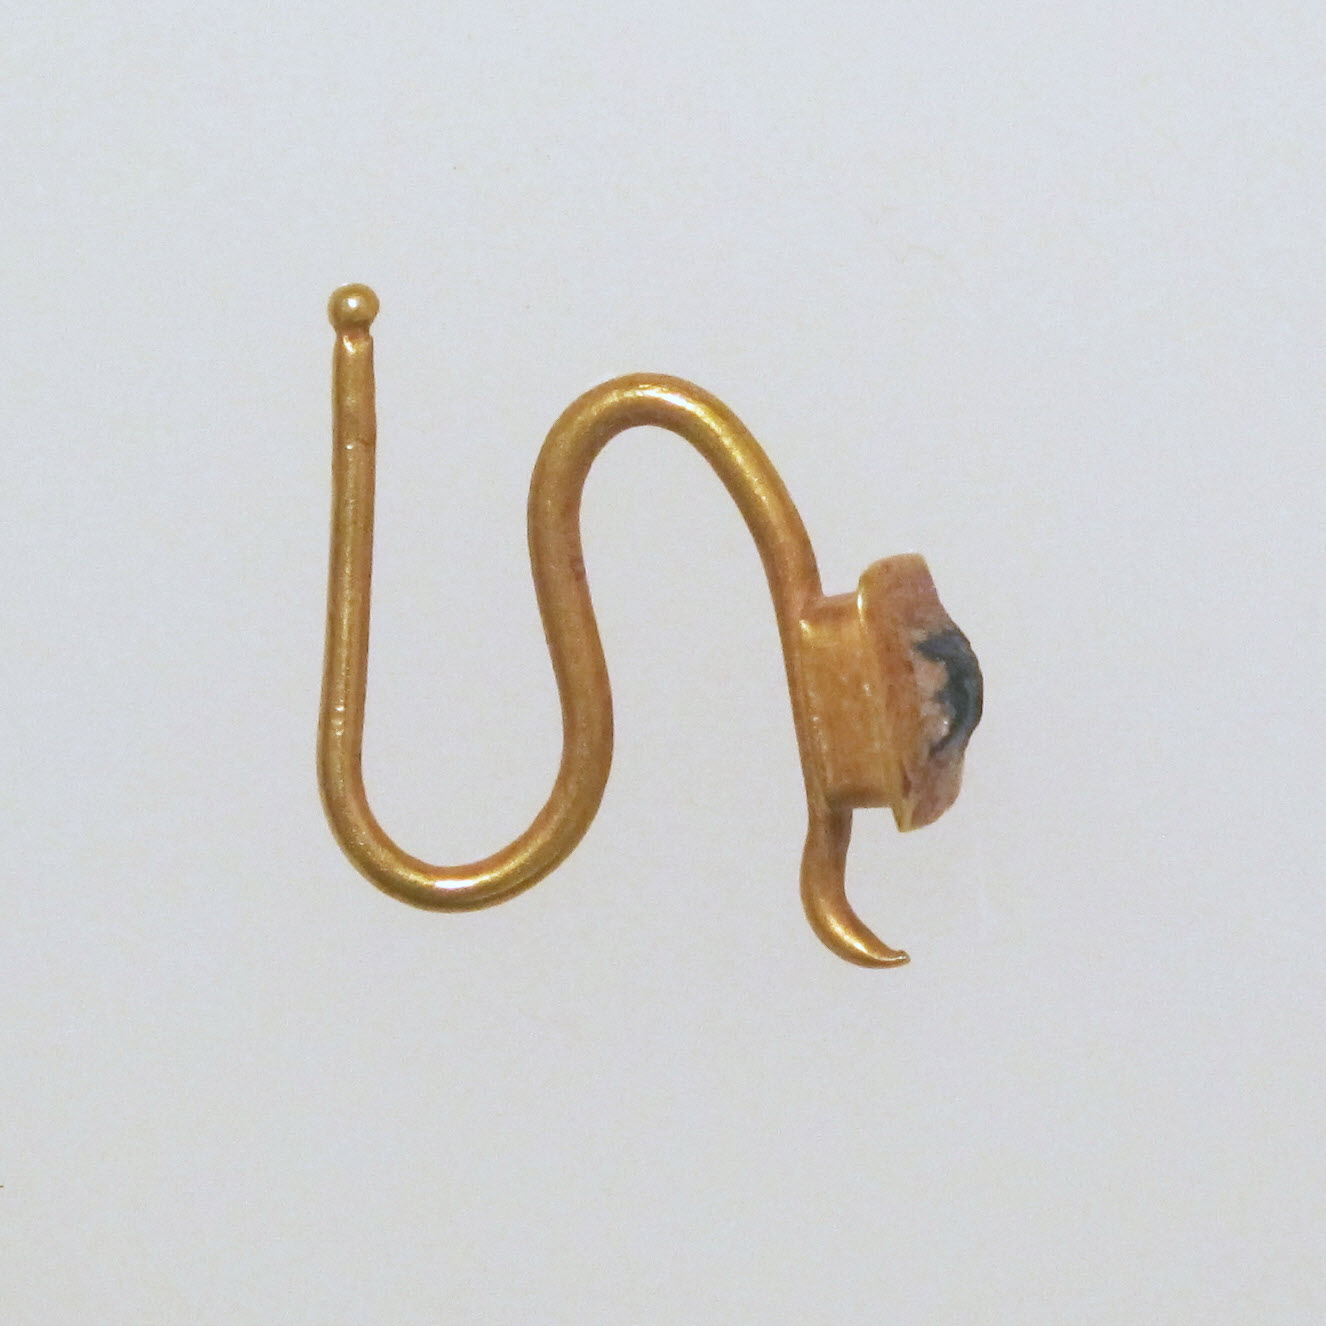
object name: earring hook type with paste setting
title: Earring-hook type with paste setting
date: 7000 BCE-330 CE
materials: glass, gold, paste